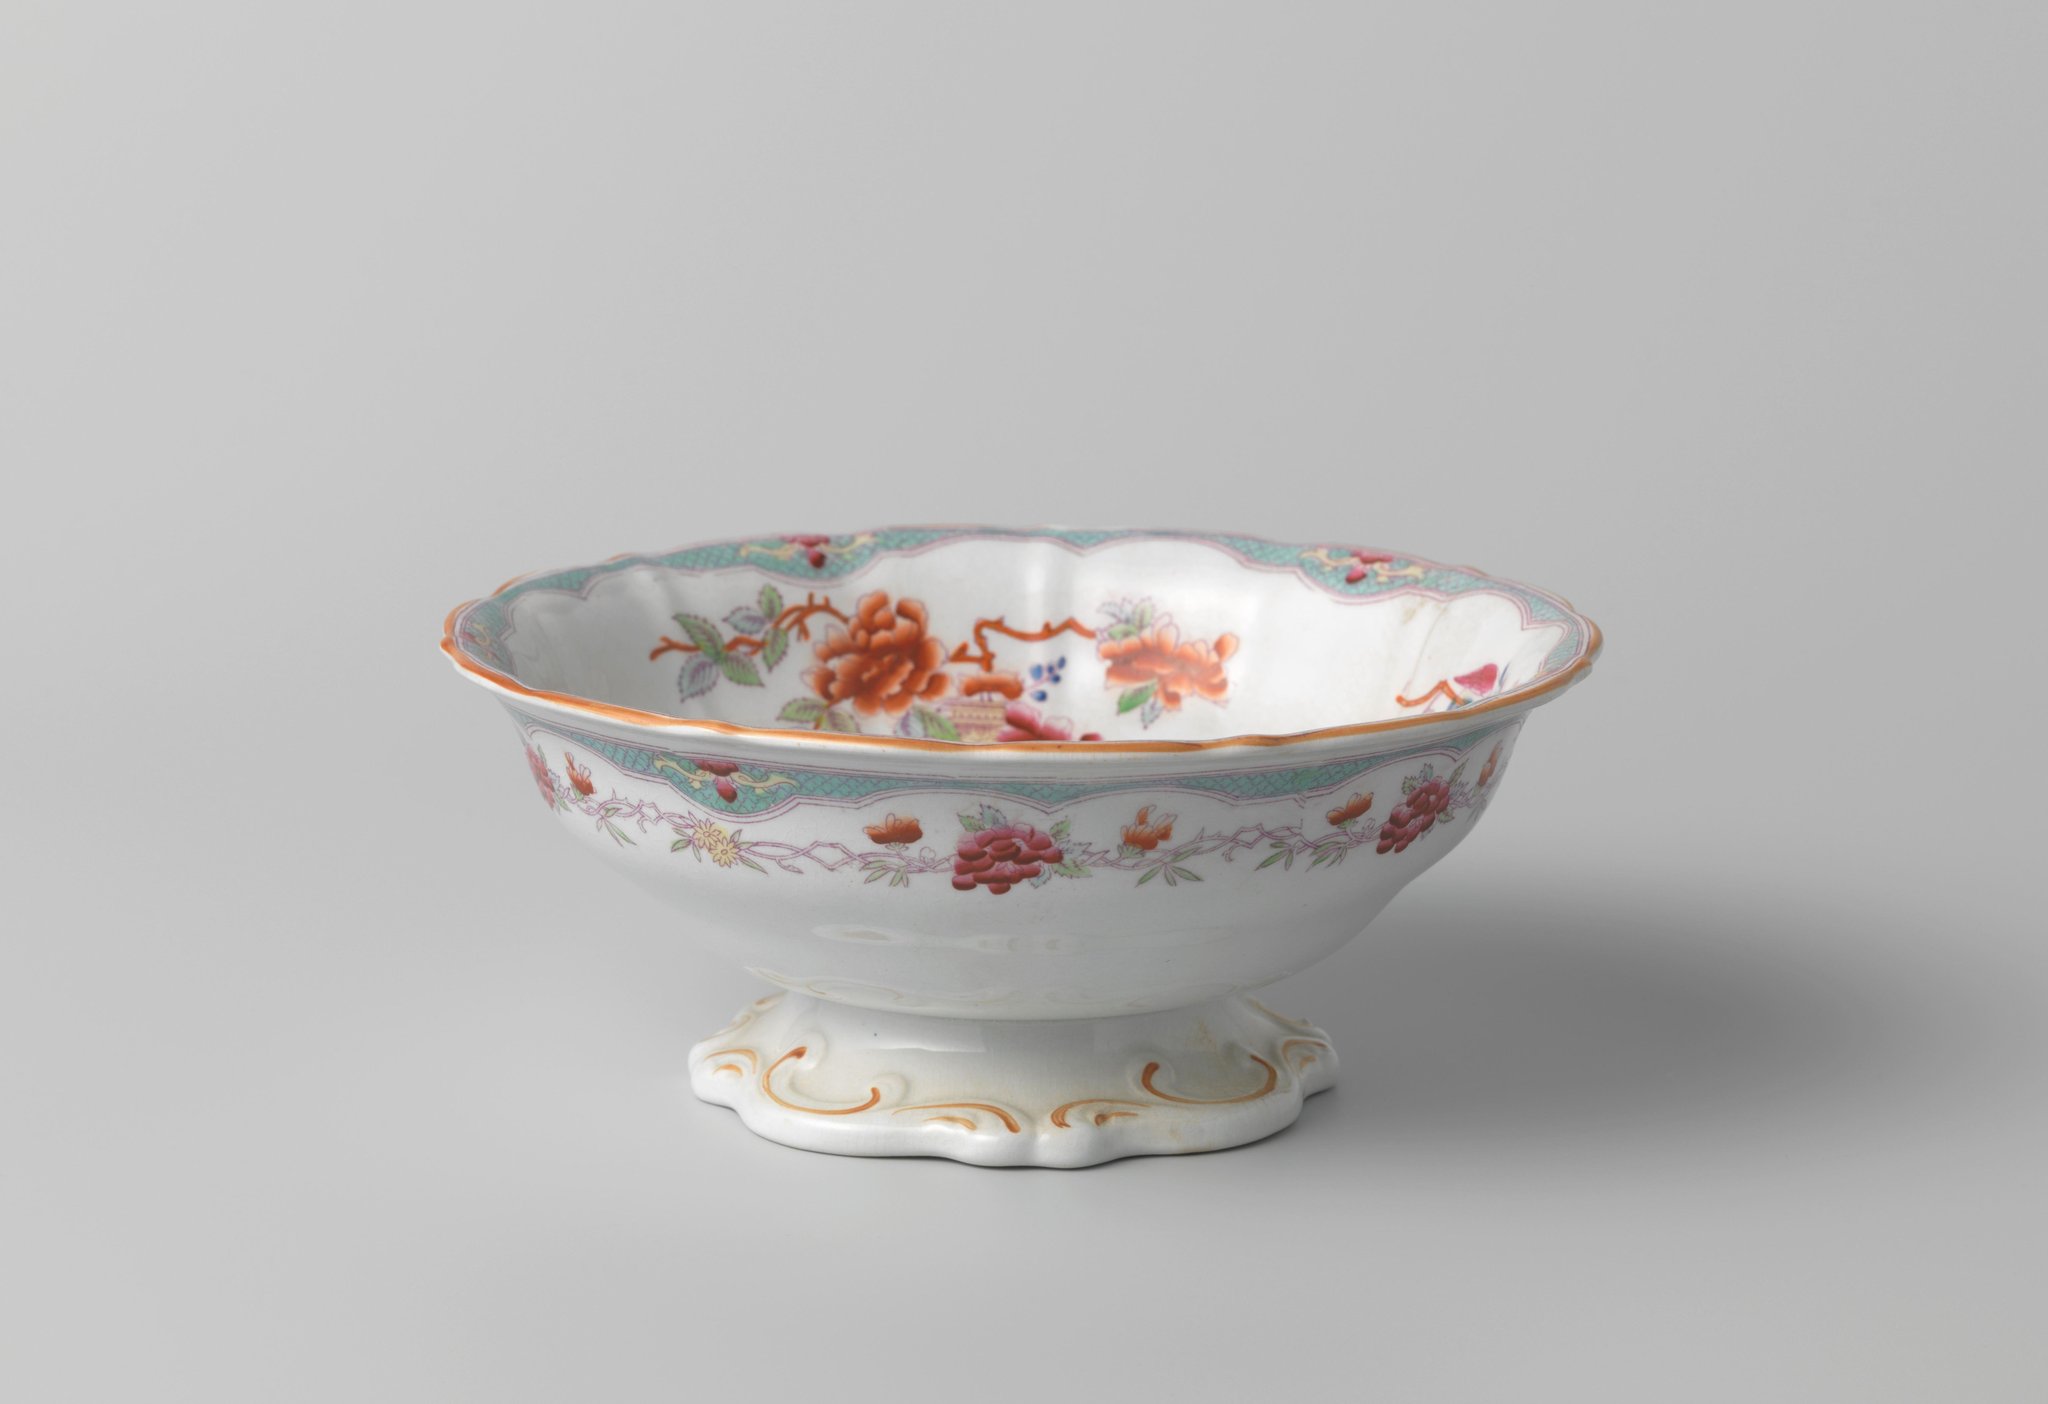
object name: bowl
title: Kom met veelkleurig decor met een tuinvaas, een hek en bloemen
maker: petrus regout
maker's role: plateelbakker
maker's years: 1801-1879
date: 1860-1890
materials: creamware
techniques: muffling, transfer decoration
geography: maastricht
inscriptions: mark: ‘PORTICI // PIERRE REGOUT’, mark: ‘7’, check stamp: ‘P. REGOUT. MAASTRICHT. 13x.’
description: Kom van aardewerk met lila transferdecor en moffelkleuren. Het veellobbig lichaam aan de buitenzijde met veelkleurig decor met een tuinvaas, een hek, bloemen en bladeren en een vogel. De wanden van de binnenzijde met een tuinvaas, een hek, bloemen en bladeren en een vogel. Op de bodem bloemen en bladeren. De uitstaande voet met voluten in reliëf, aangezet met oranje. .